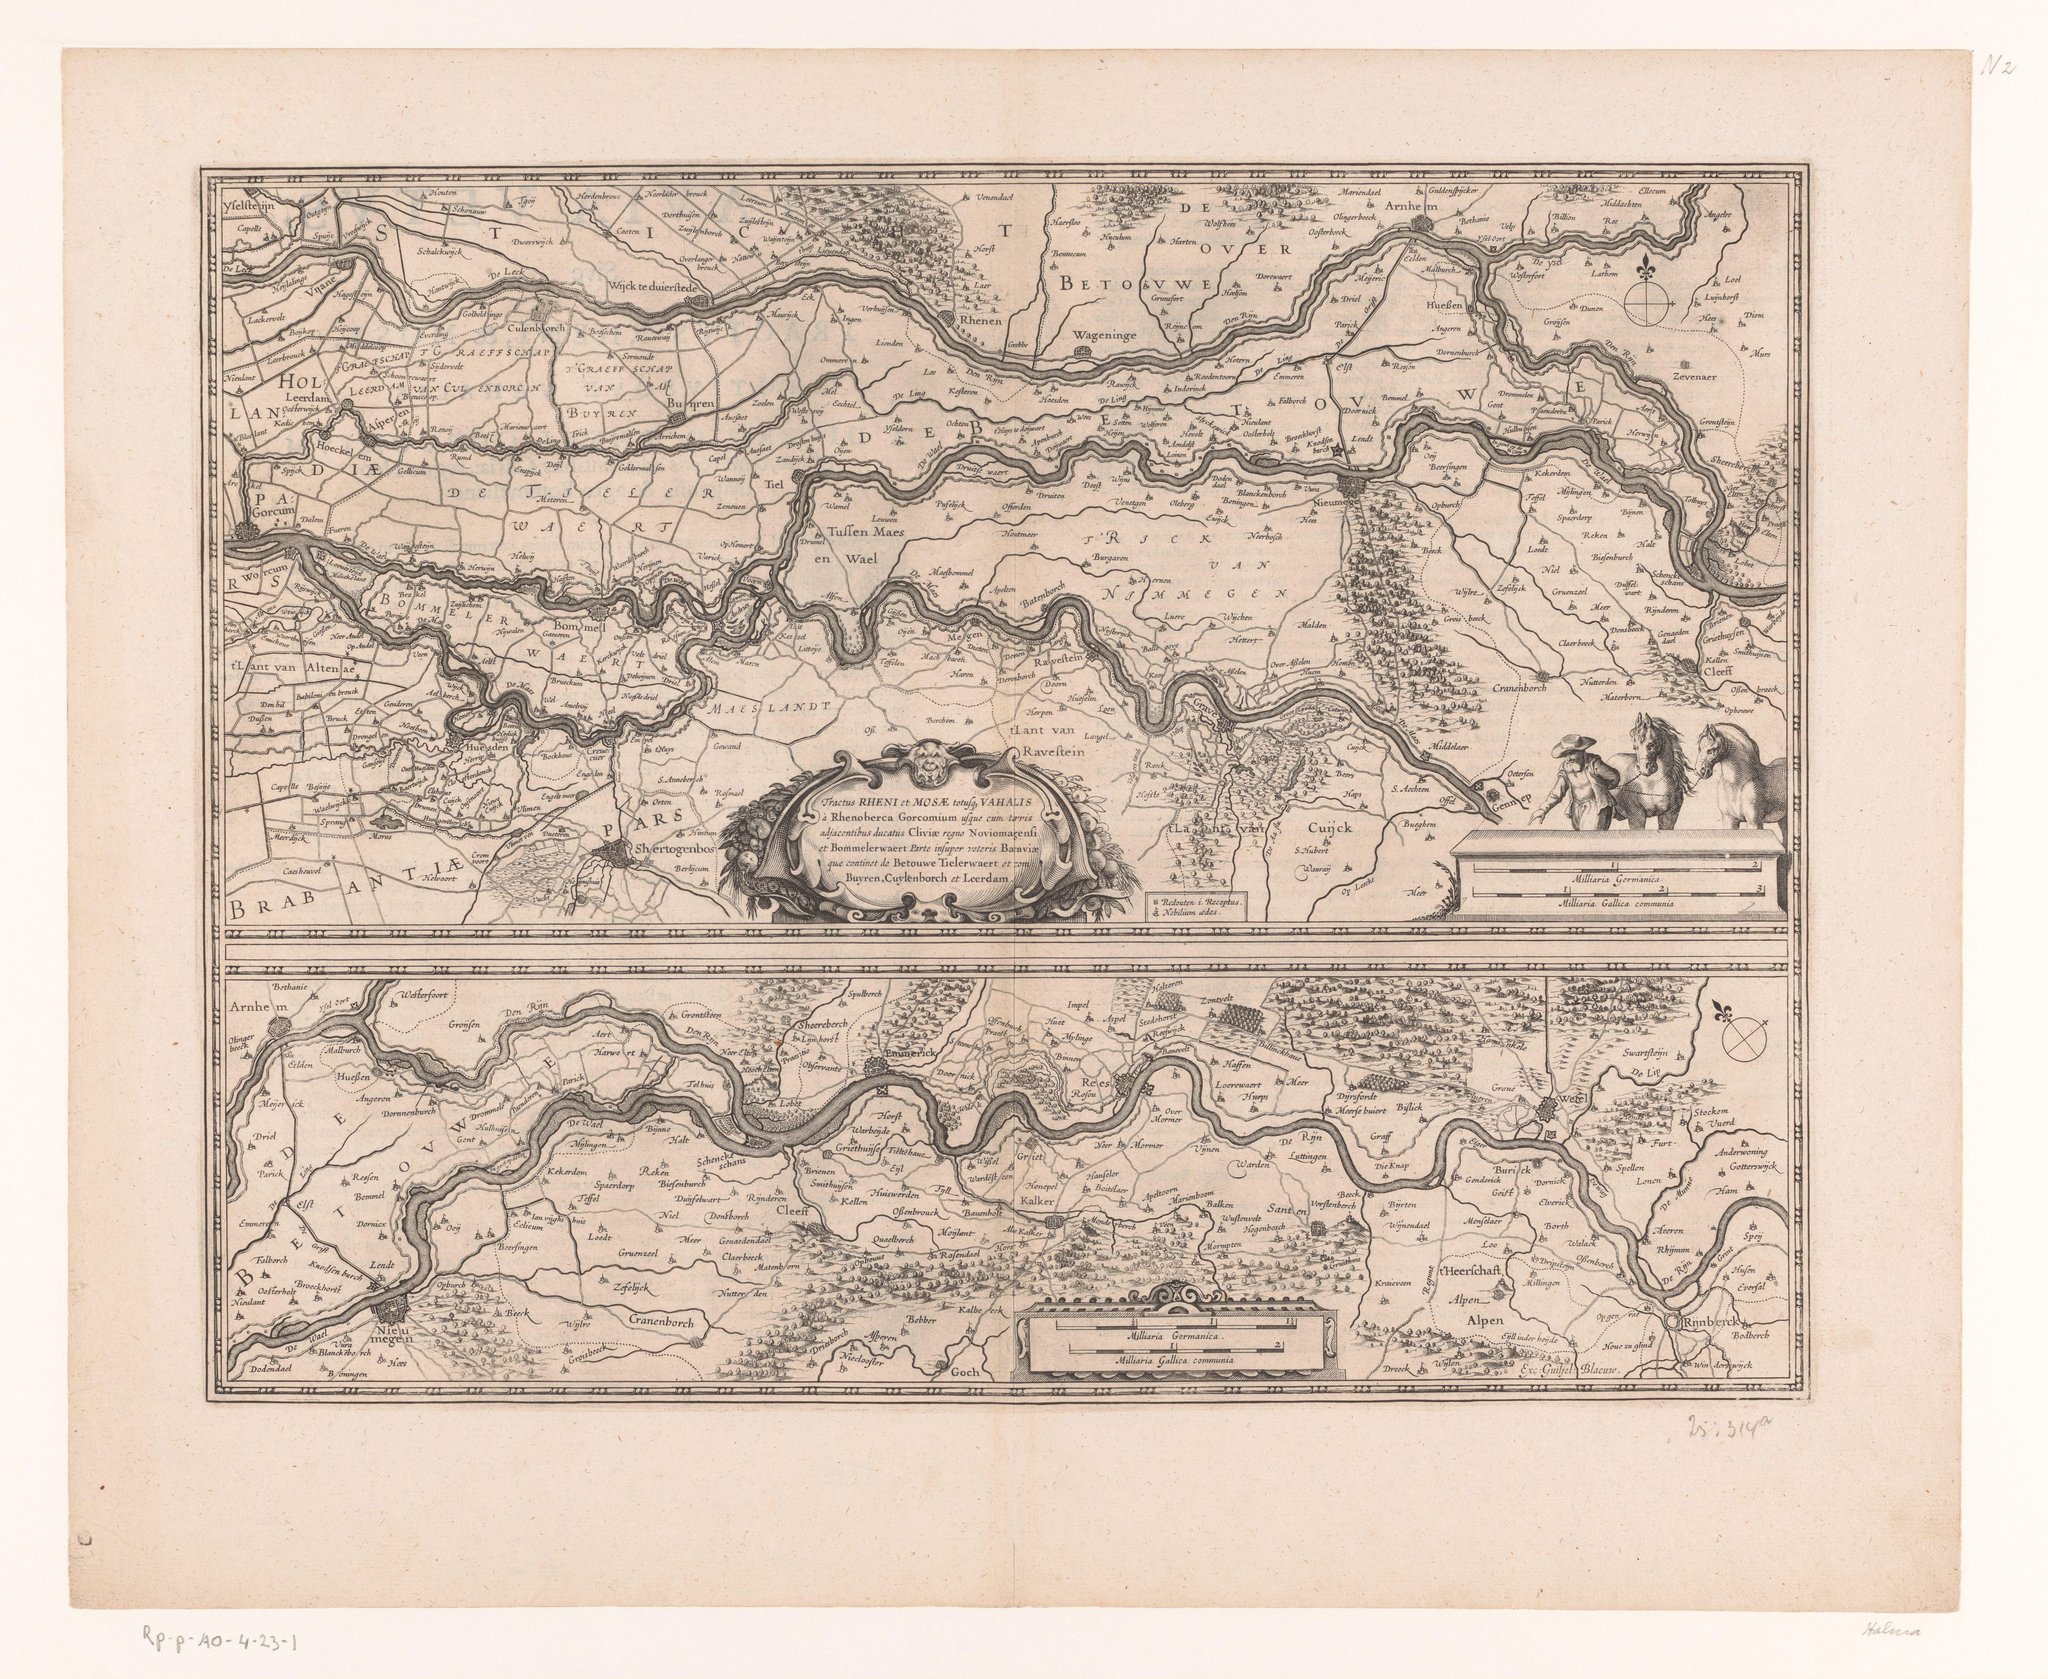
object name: print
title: Kaart van een deel van het verloop van de Rijn, de Waal en de Maas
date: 1631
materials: paper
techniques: engraving, etching, letterpress printing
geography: amsterdam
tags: maps of separate countries or regions, river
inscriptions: collector's mark: Lugt 2228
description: De kaart bestaat uit twee delen. Boven in het midden de titelcartouche. Rechts daarvan een legenda. Rechts in het midden een cartouche met twee schaalstokken: 2 Milliaria Germanica / 3 Milliaria Gallica communia. Onder in het midden nog een cartouche met twee schaalstokken: 1 1/2 Milliaria Germanica / 2 Milliaria Gallica communia. Met Latijnse tekst op verso.